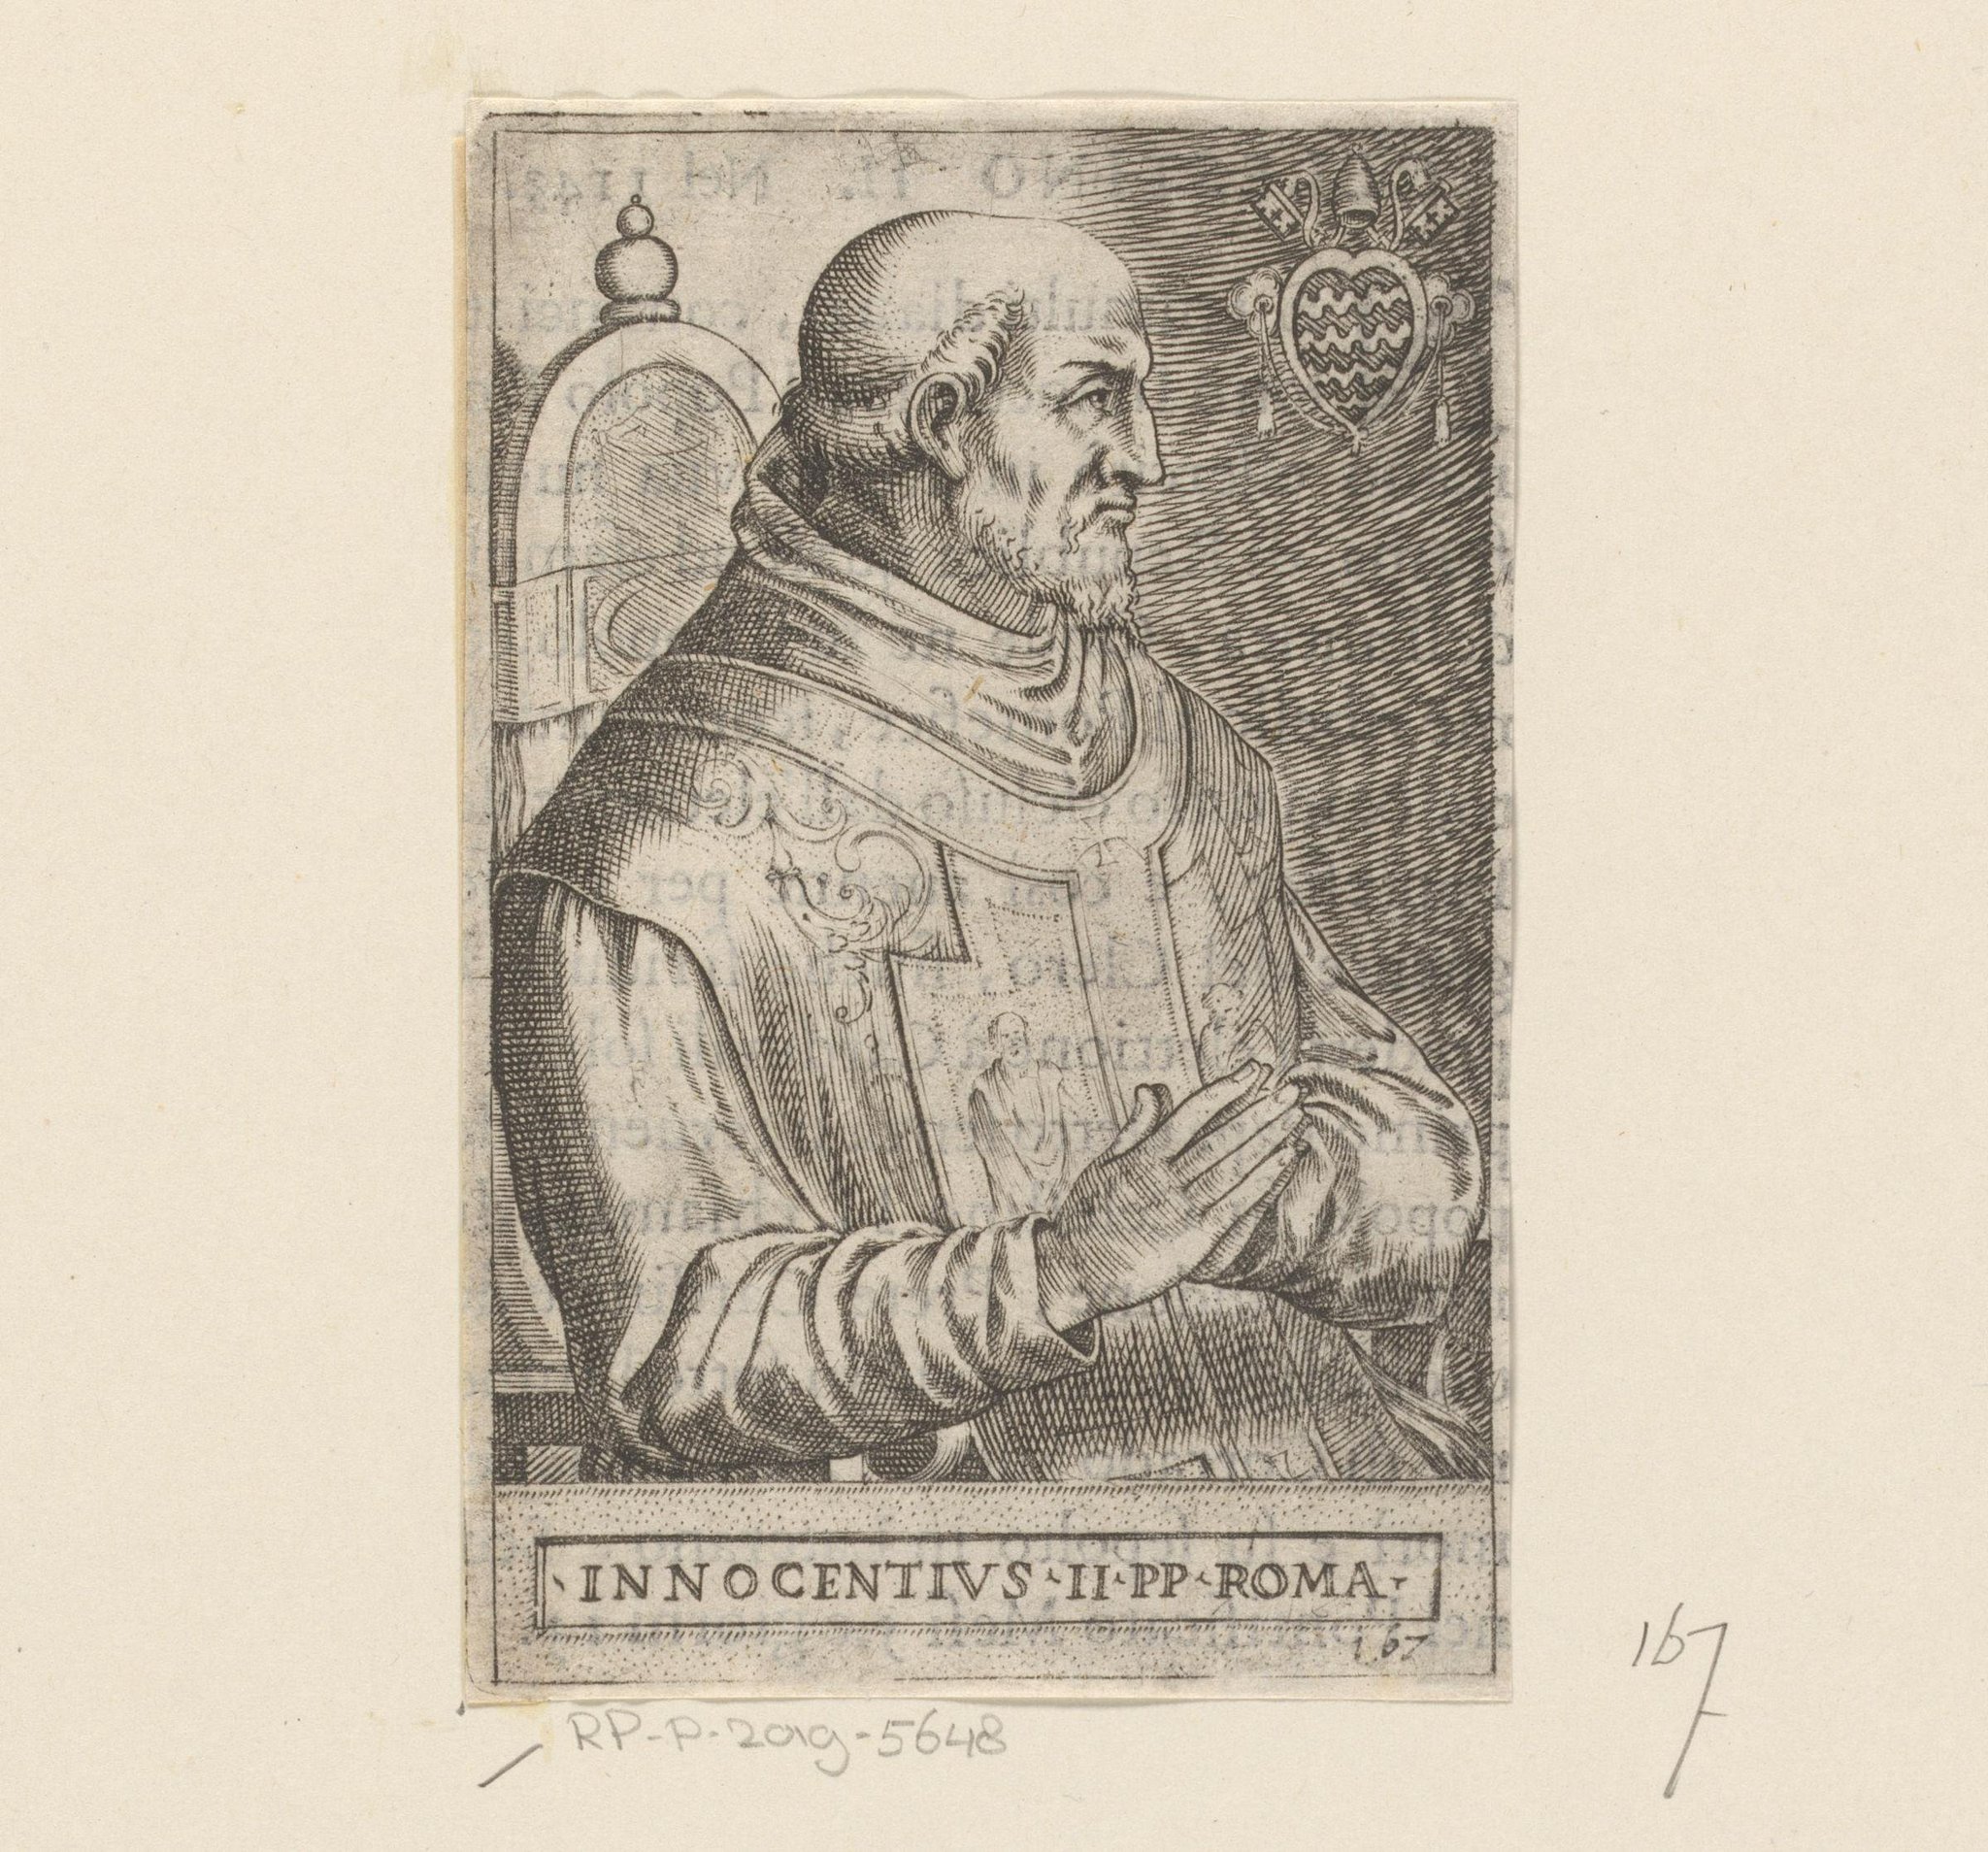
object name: print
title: Portret van paus Innocentius II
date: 1624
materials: paper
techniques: engraving, letterpress printing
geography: rome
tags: historical persons, pope, armorial bearing, heraldry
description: Prent uit: Tempesta, Domenico. Vite et effigie di tutti li pontefici romani (...). Rome: Giacomo Crulli de Marcucci, 1624. Eerdere staat van prent voor het eerst verschenen in: Cavalieri, Giovanni Battista de'. Pontificum romanorum effigies (...). Rome: Domenico Basa en Francesco Zanetti, 1580. Prent ook gebruikt in latere publicaties.